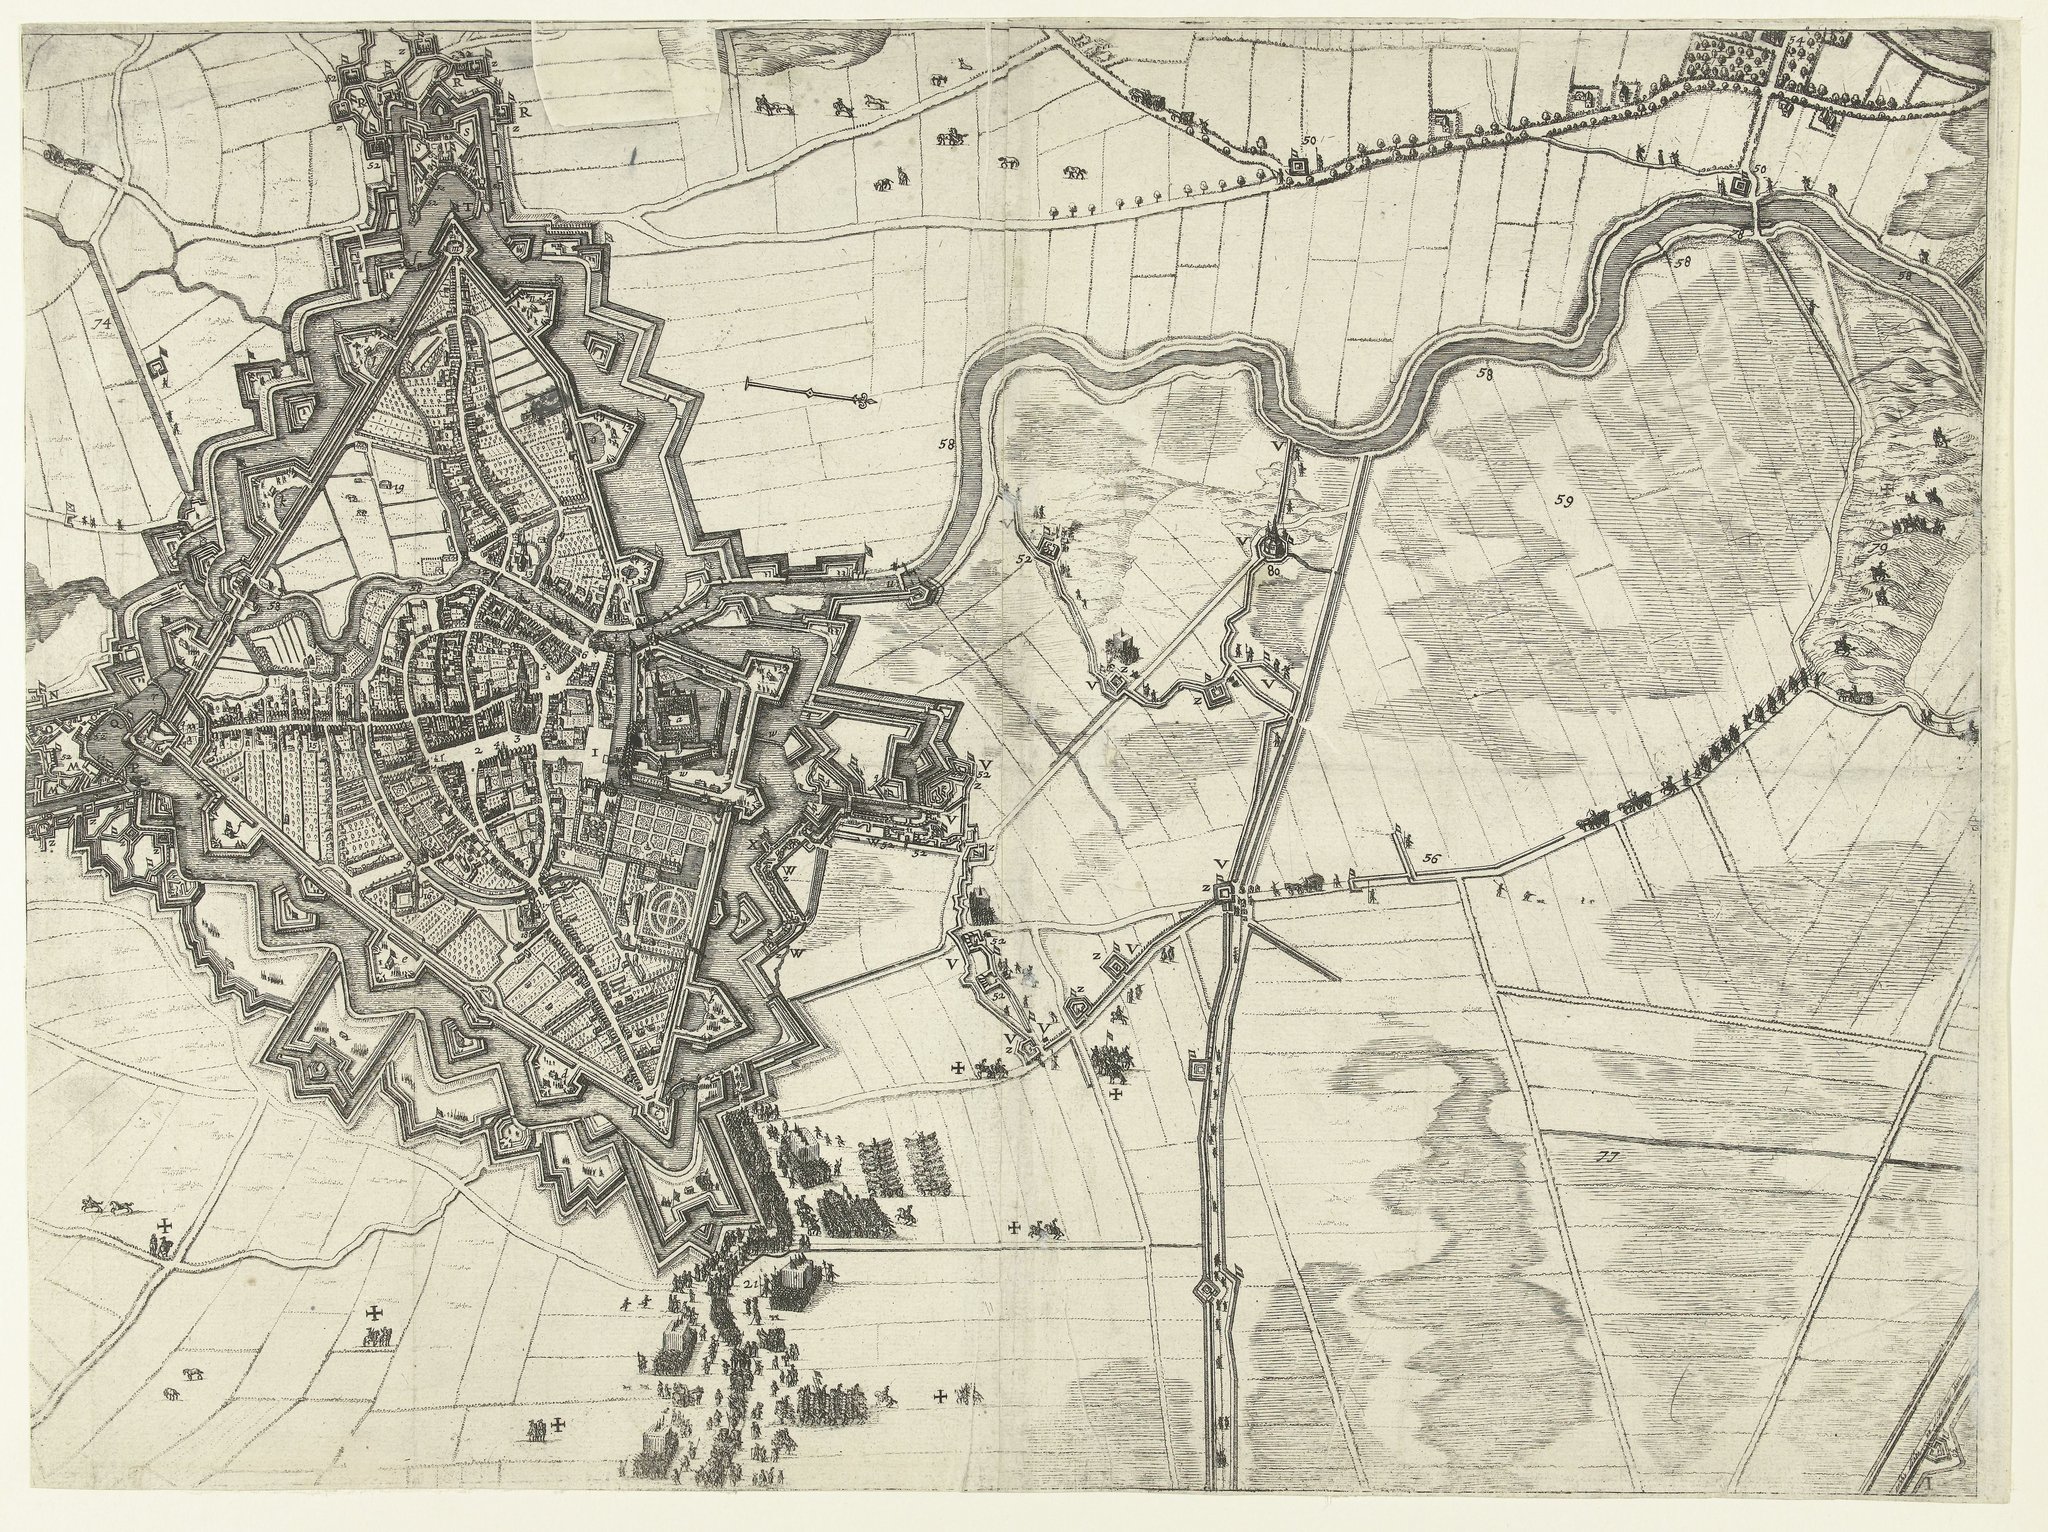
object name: map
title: Expugnatio Fortissimae Urbis Bredae Ao.-1637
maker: balthasar florisz. van berckenrode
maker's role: draughtsman, print maker, publisher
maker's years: 1591-1645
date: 1637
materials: paper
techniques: etching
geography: northern netherlands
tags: frederick henry (prince of orange), maps of separate countries or regions, siege, position war, maps of cities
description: De belegering en verovering van Breda door het Staatse leger onder Frederik Hendrik, 23 juli - 10 oktober 1637. Onderdeel van een ongemonteerde ensemble bestaande uit 9 bladen (en 2 hier ontbrekende tekstbladen). Blad middenmidden met de plattegrond van Breda.